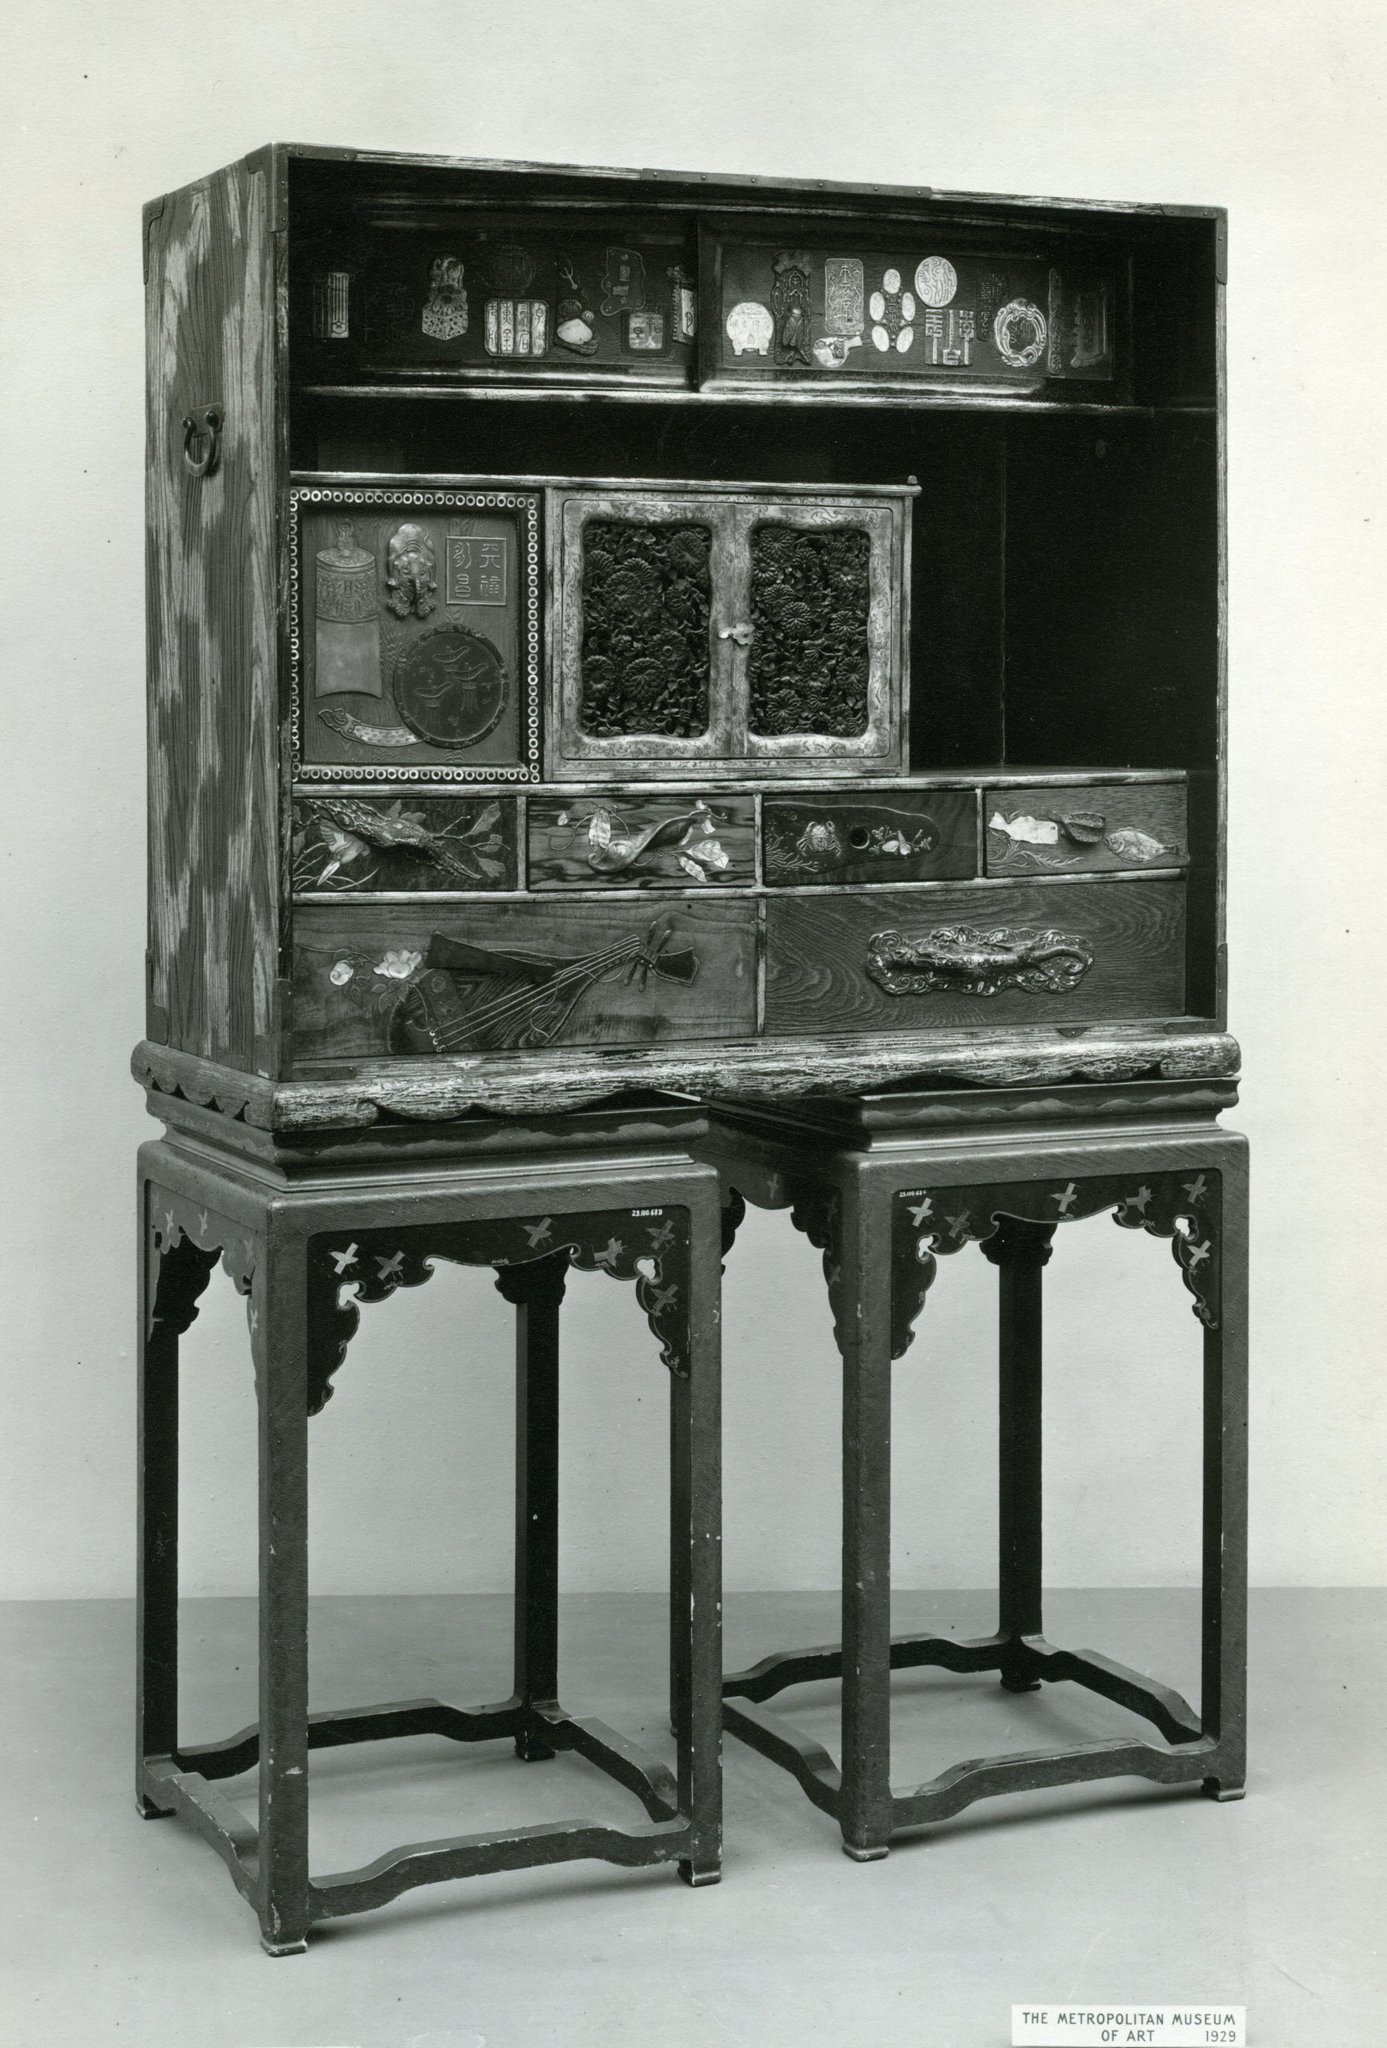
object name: cabinet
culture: japanese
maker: ogawa haritsu (ritsuō)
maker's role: artist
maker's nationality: japanese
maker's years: 1663-1747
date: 1663-1747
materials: wood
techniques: lacquer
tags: cabinets